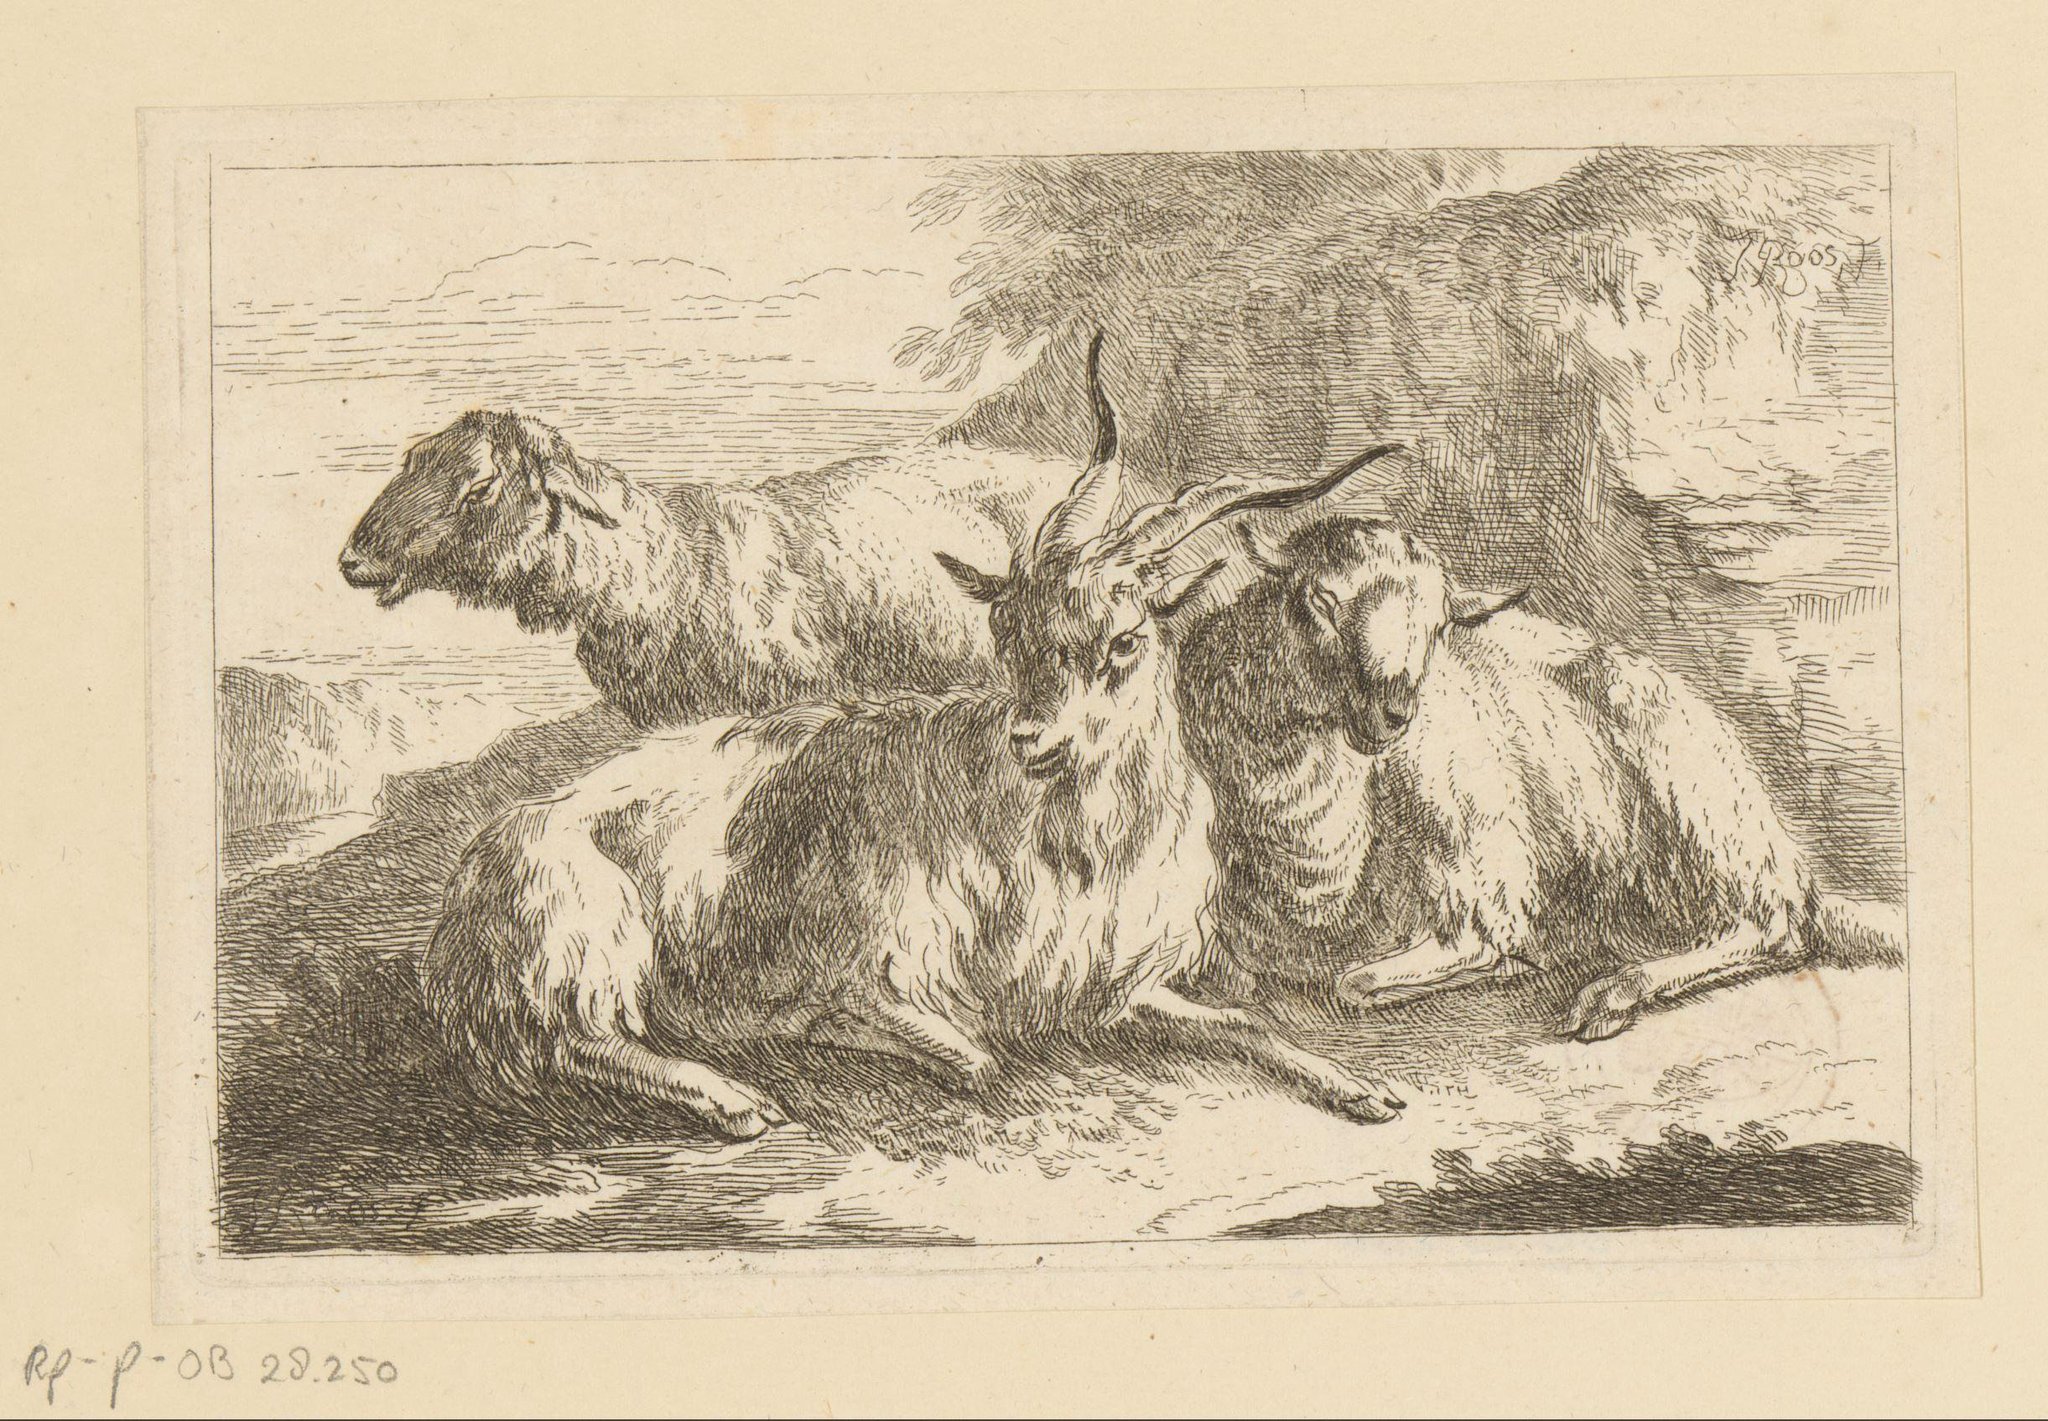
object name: print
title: Schapen en geiten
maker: joseph roos (i)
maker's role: print maker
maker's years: 1726-1805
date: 1754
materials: paper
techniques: etching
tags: landscapes, sheep, goat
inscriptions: collector's mark: Lugt 240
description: Serie van twaalf prenten, waarvan één titelprent.